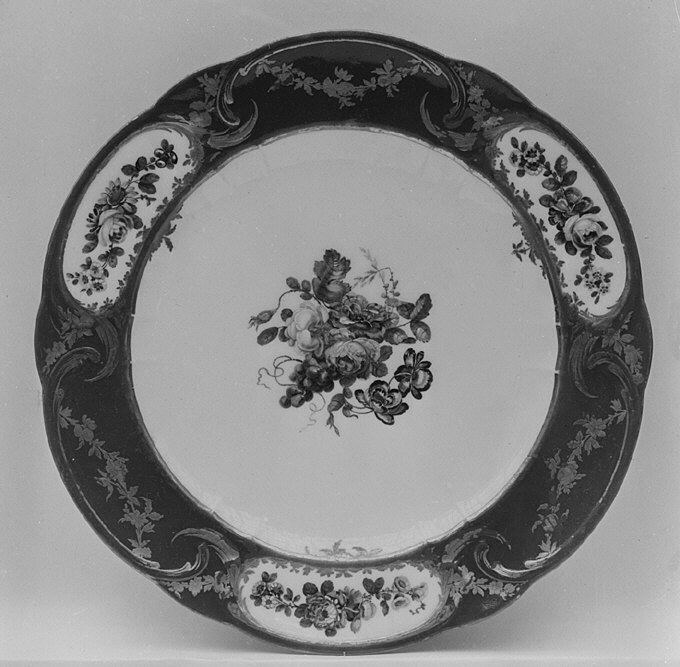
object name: plate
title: Plate (Assiette à palmes) (1 of 102) (part of a service)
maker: sèvres manufactory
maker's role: manufactory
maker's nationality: french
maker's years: 1740-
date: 1767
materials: soft paste porcelain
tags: flowers